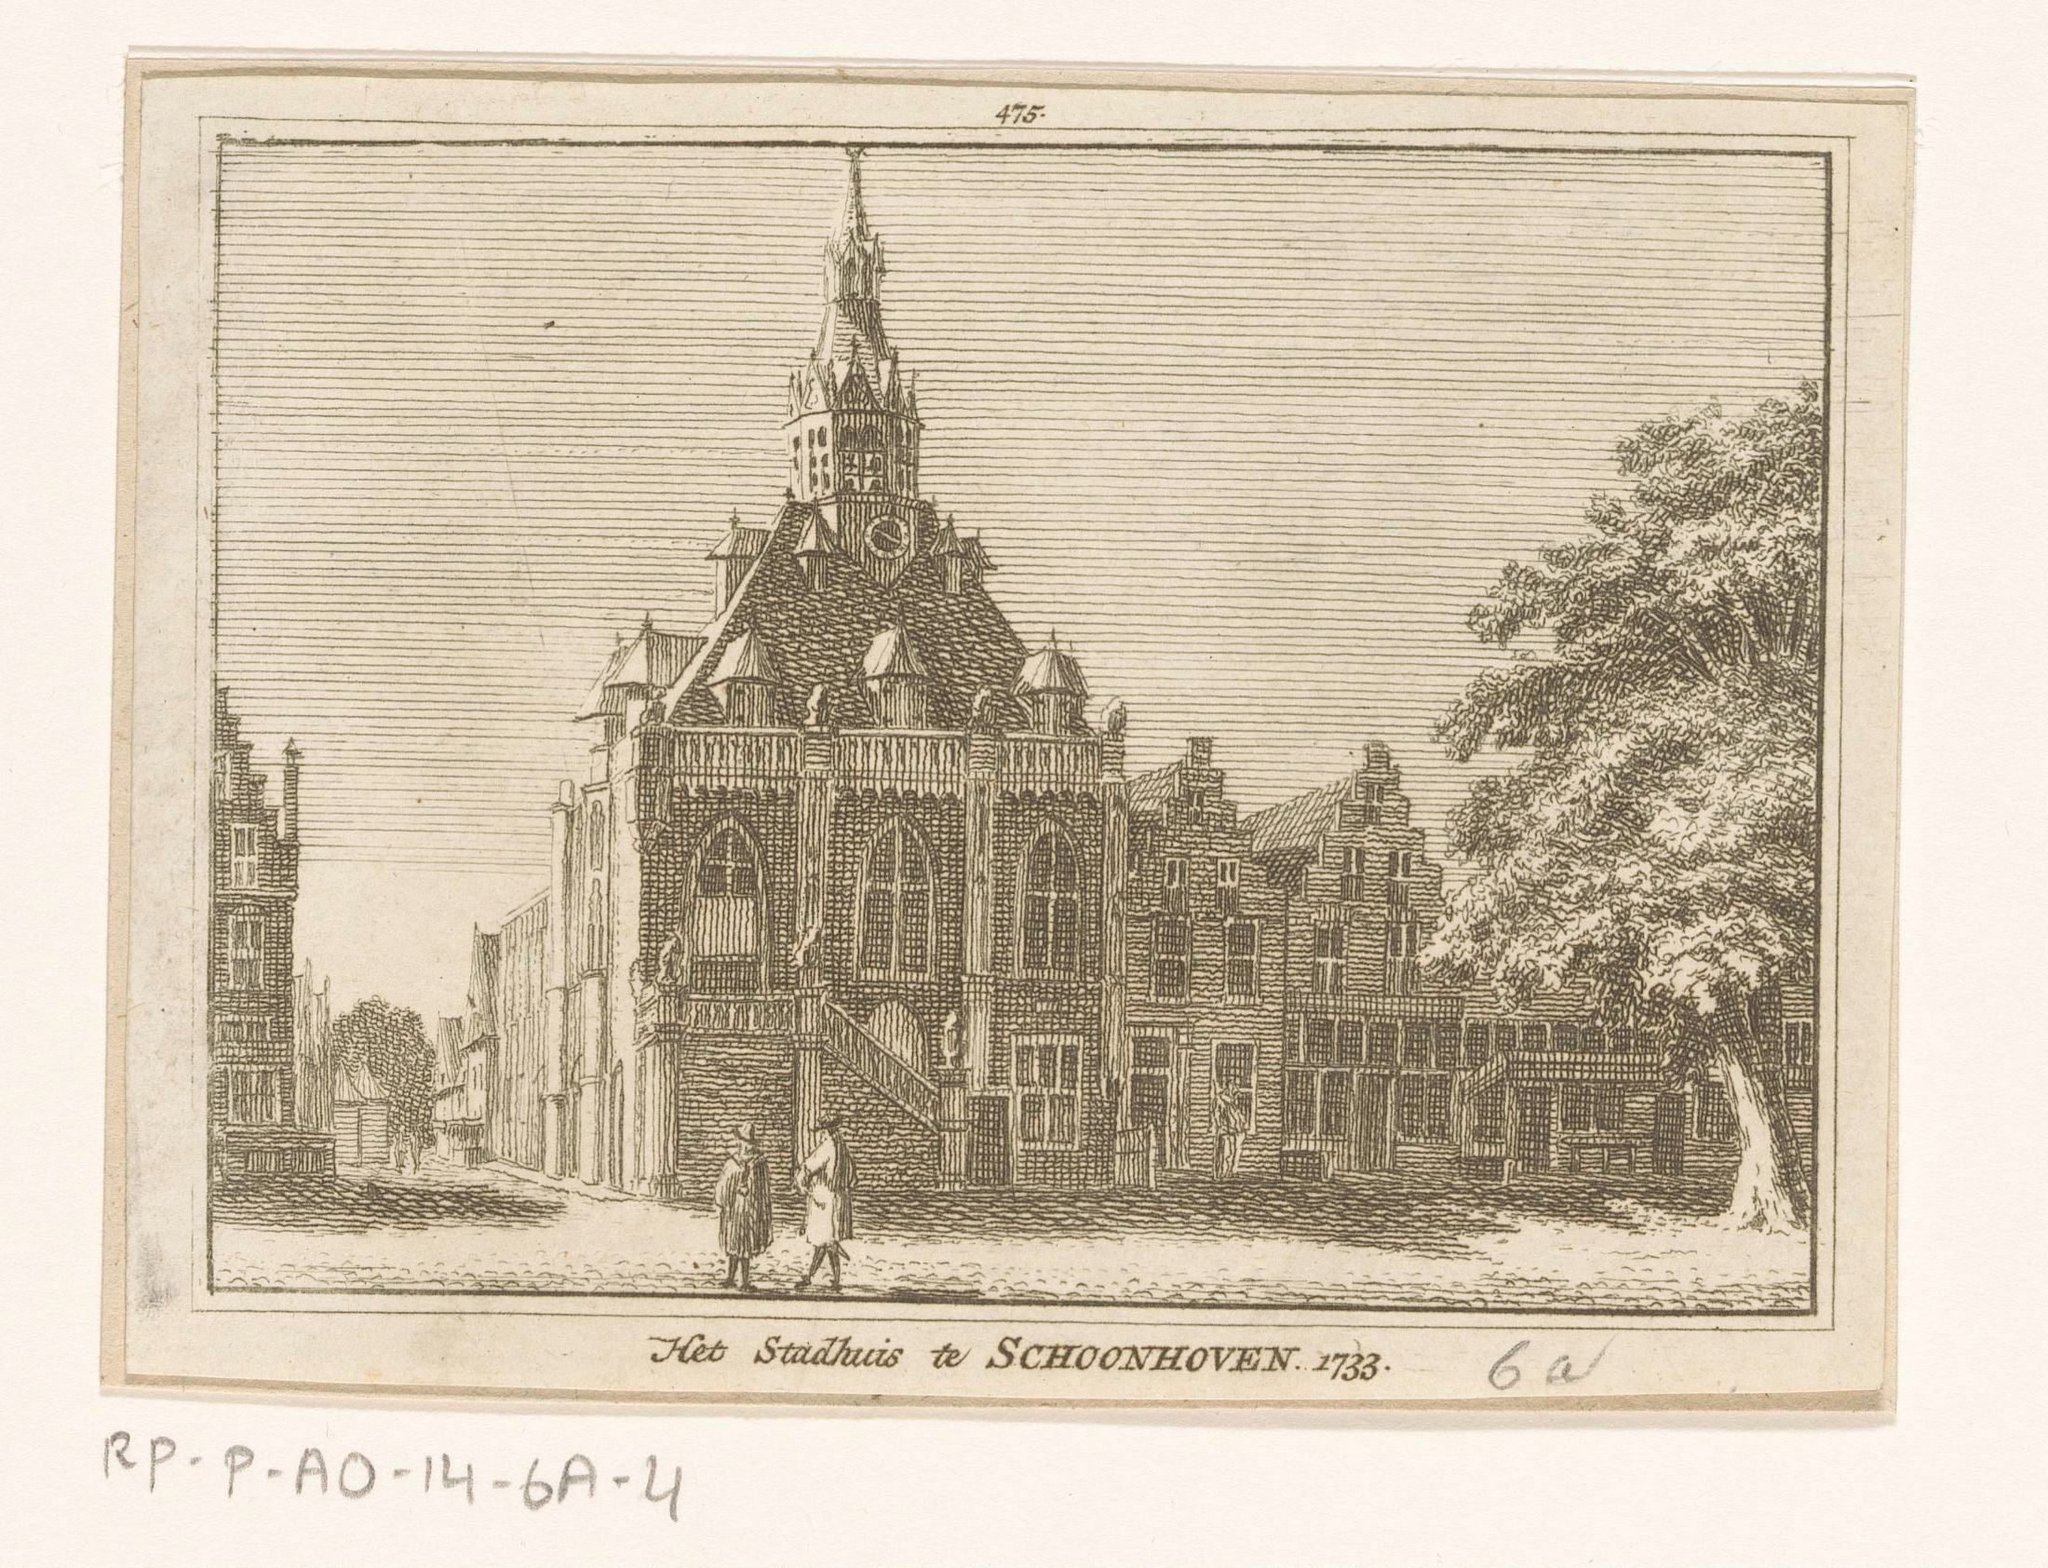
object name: print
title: Gezicht op het stadhuis te Schoonhoven, 1733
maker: hendrik spilman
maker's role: draughtsman, painter, print maker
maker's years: 1721-1784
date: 1757-1792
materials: paper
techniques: etching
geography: haarlem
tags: townhall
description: Prent ook gebruikt in: Het verheerlykt Nederland of kabinet van hedendaagsche gezigten van steden, dorpen (…). 9 delen. Amsterdam: Isaak Tirion en weduwe Isaak Tirion, 1745-1774, dl. 6 (1757), ill. 475. Of in: Nederlandsche tafereelen; of eene keurige verzameling van negen honderd fraaije gezigten van steden, dorpen, sloten, oudheden (….). 9 delen. Amsterdam: Jan de Groot, 1792, dl. 6, ill. 475.